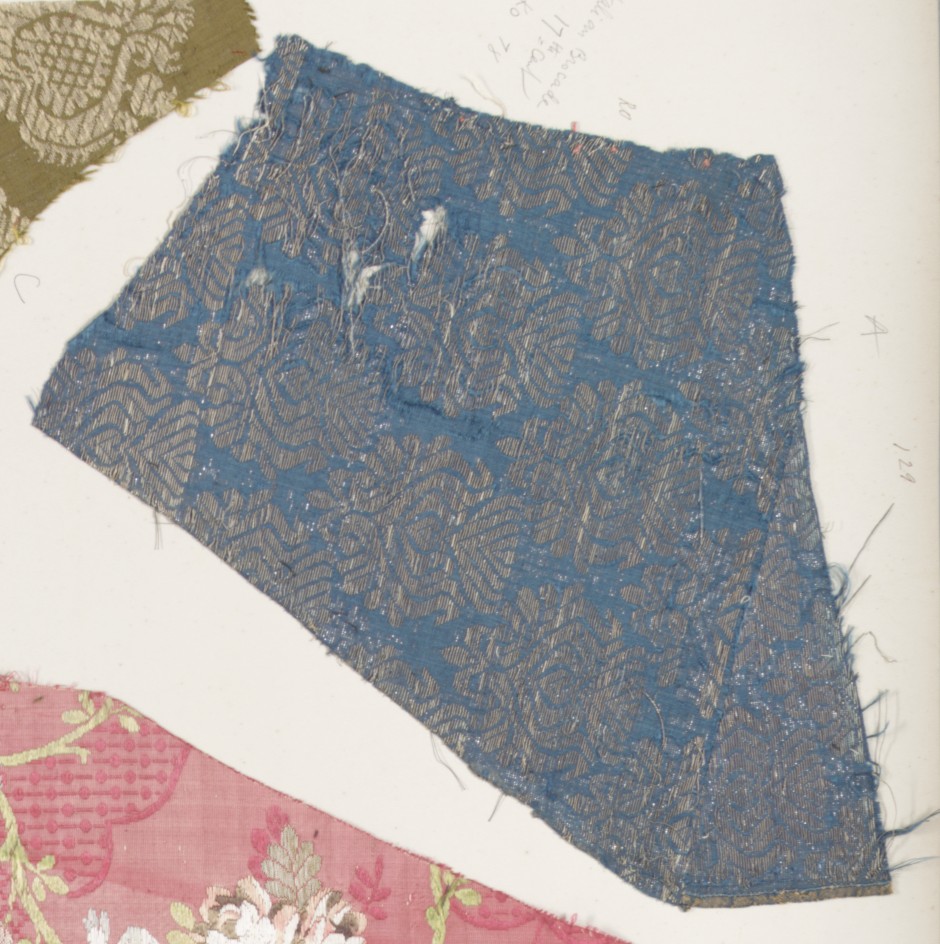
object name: fragment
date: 1601-1700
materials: metal thread, silk